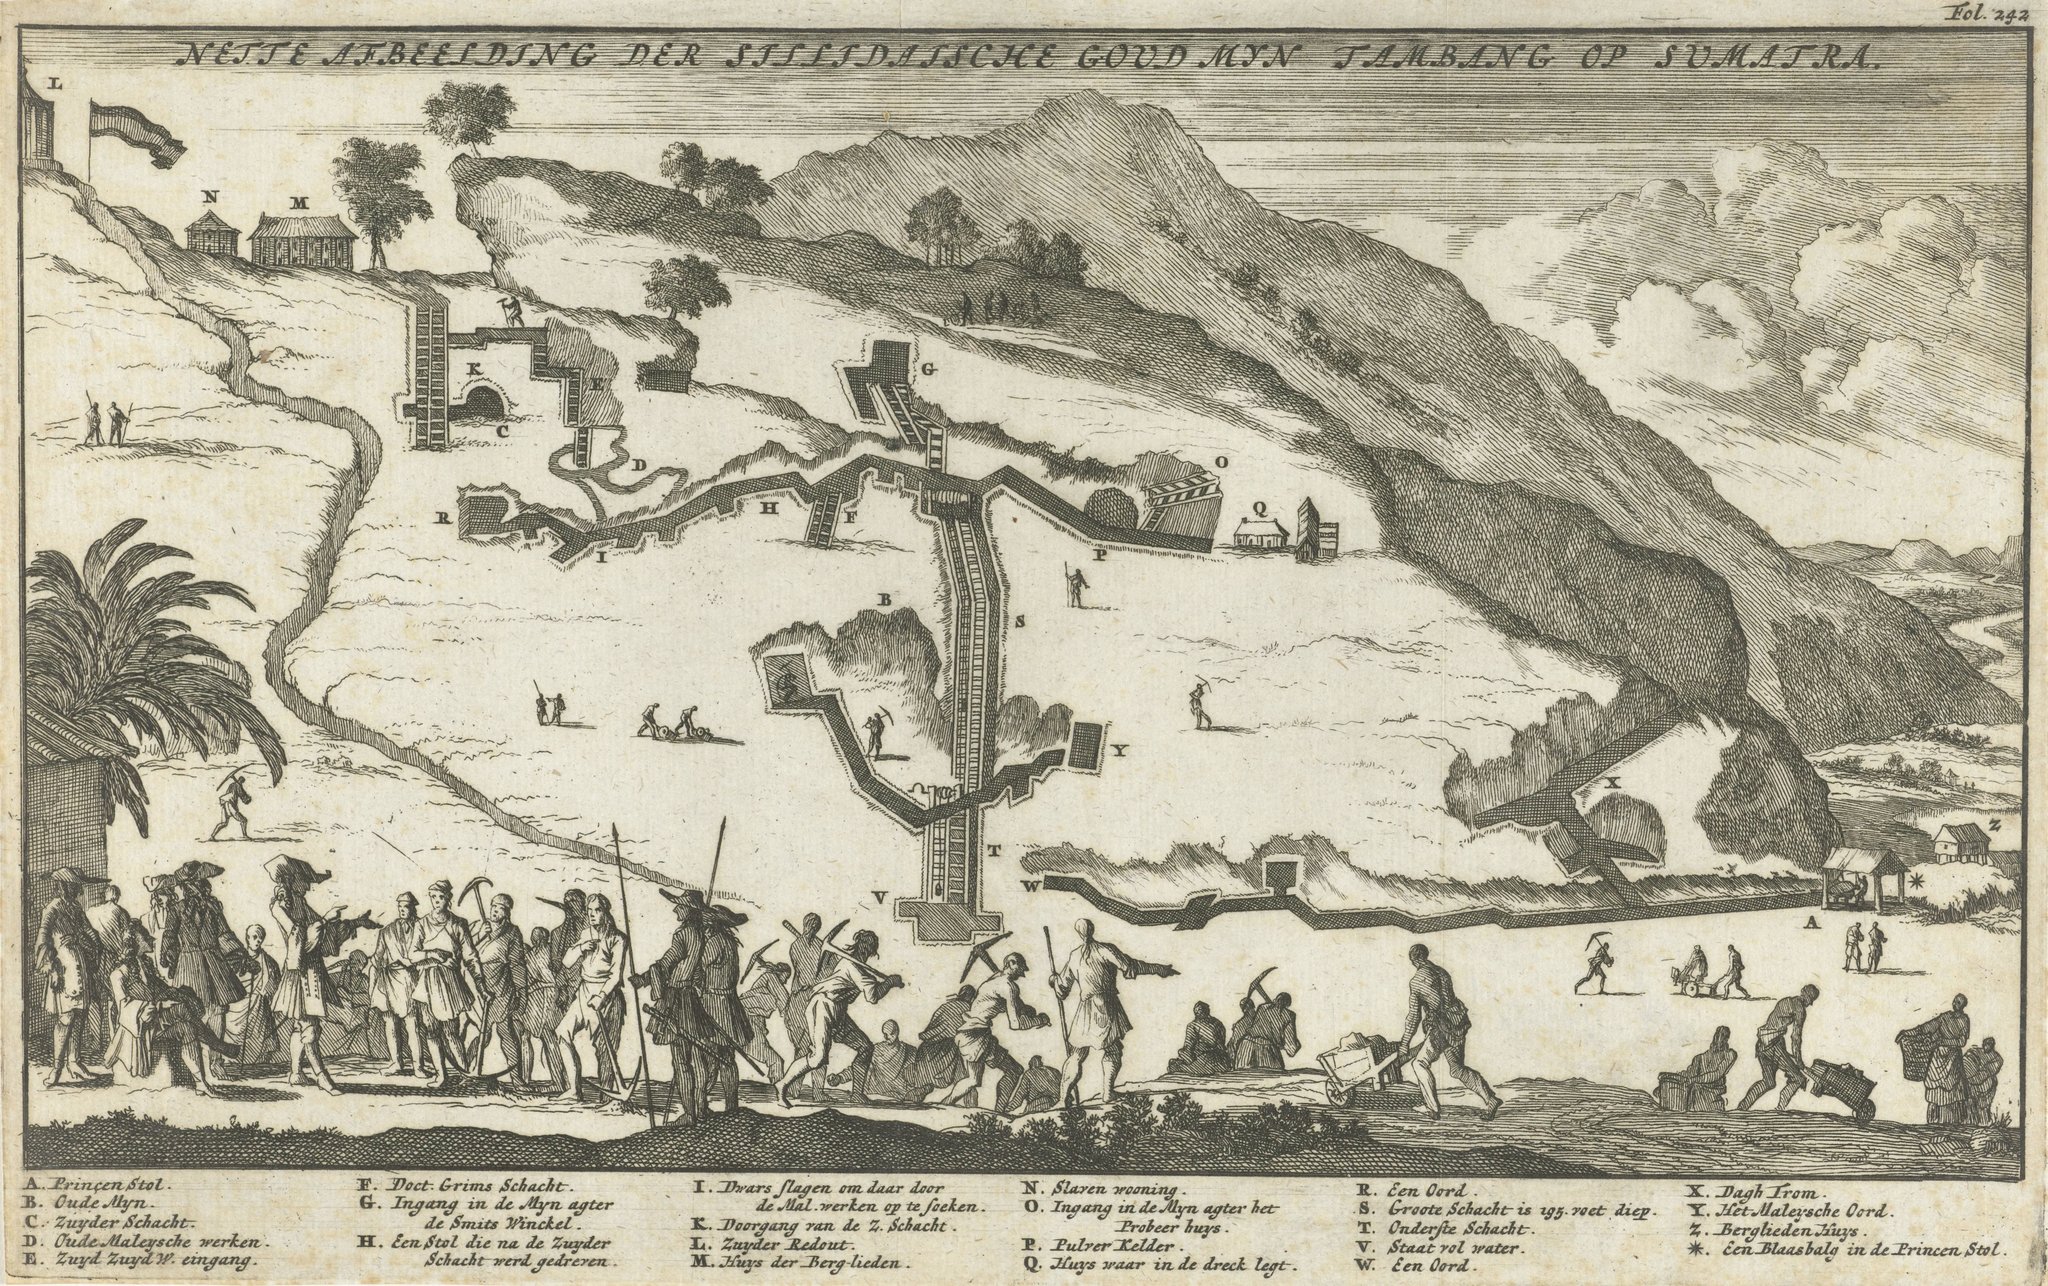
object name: book illustration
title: Goudmijn Tambang te Sumatra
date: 1694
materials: paper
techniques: etching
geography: utrecht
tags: mine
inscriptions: collector's mark: Lugt 2228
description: Illustratie uit: Frik, Christoff. Drie seer aenmercklijcke reysen nae en door veelerley gewesten in Oost-Indien. Amsterdam: Willem van de Water, 1694.